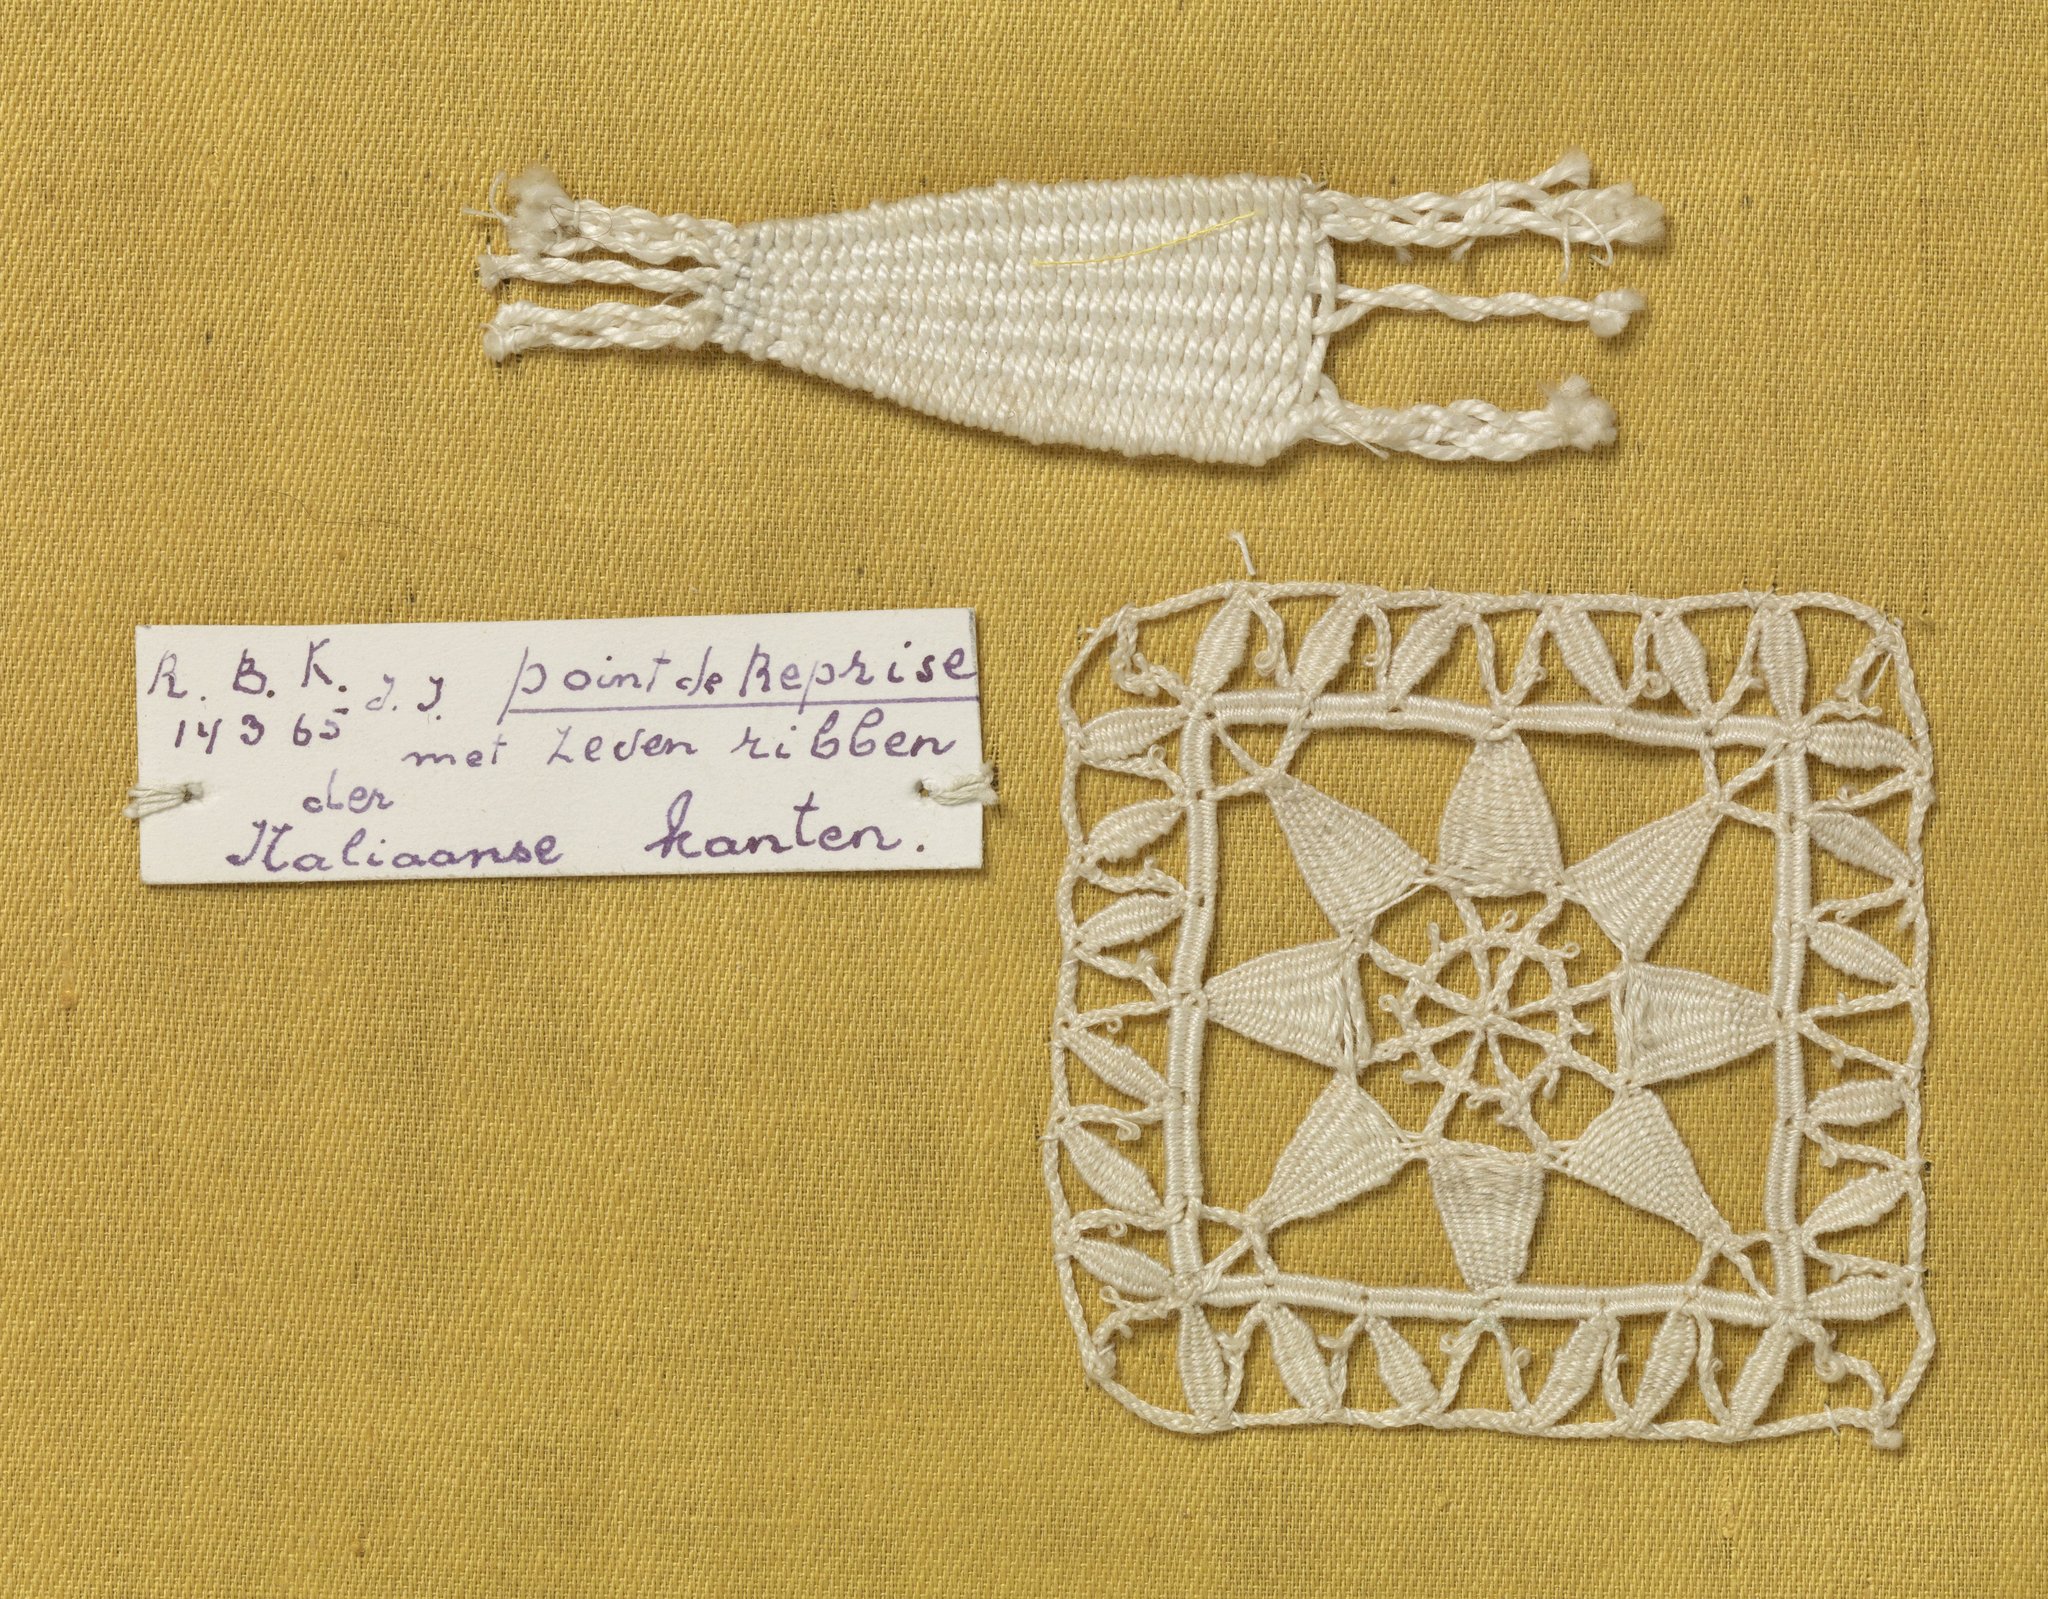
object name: sample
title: Staal kloskant met grove draad als voorbeeld van vormslag met zeven ribben met daarbij een fragment kant waarin deze techniek is toegepast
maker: Anonymous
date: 1900-1930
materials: cotton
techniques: lace, tally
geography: western europe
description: Staal naturelkleurige kloskant met grove draad als voorbeeld van vormslag met zeven ribben met daarbij een fragment kant waarin deze techniek is toegepast. De datering betreft het staal.